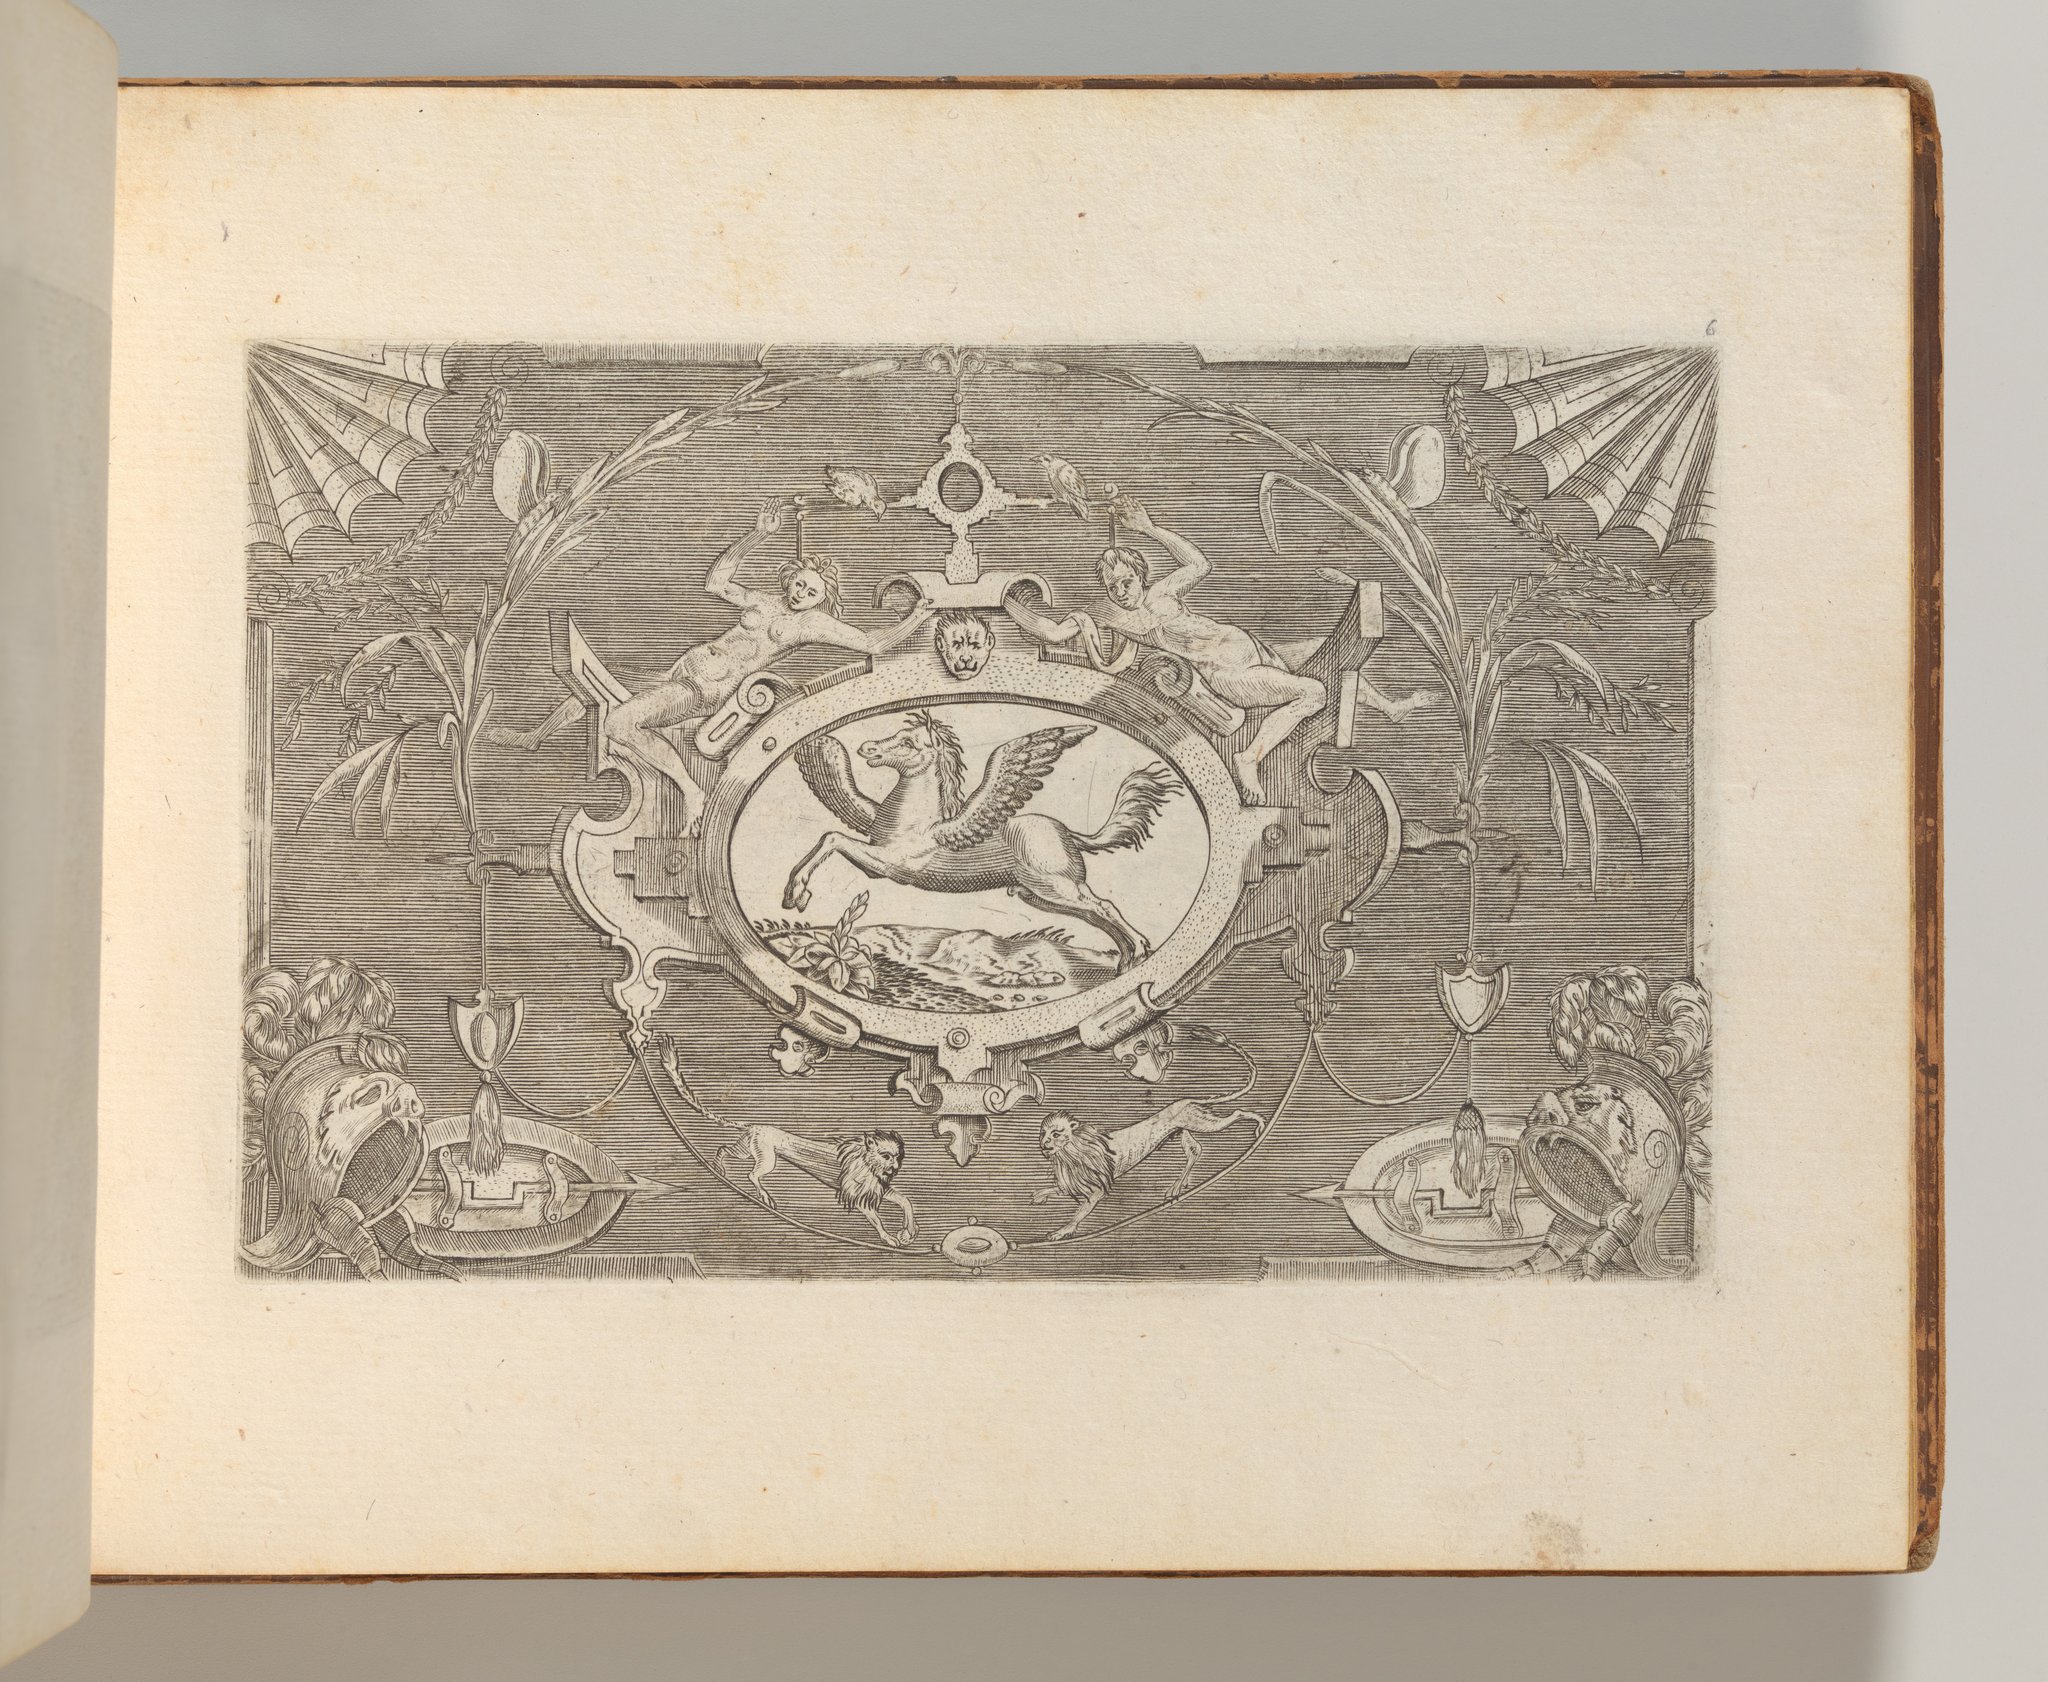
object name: album print ornament architecture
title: Targhe ed altri ornati di varie e capricciose invenzioni (Cartouches and other ornaments of various and capricious invention, page 6)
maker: jacob floris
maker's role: artist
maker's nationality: central european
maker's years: 1524-1581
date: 1773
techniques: engraving, etching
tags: cartouches,pegasus,lions